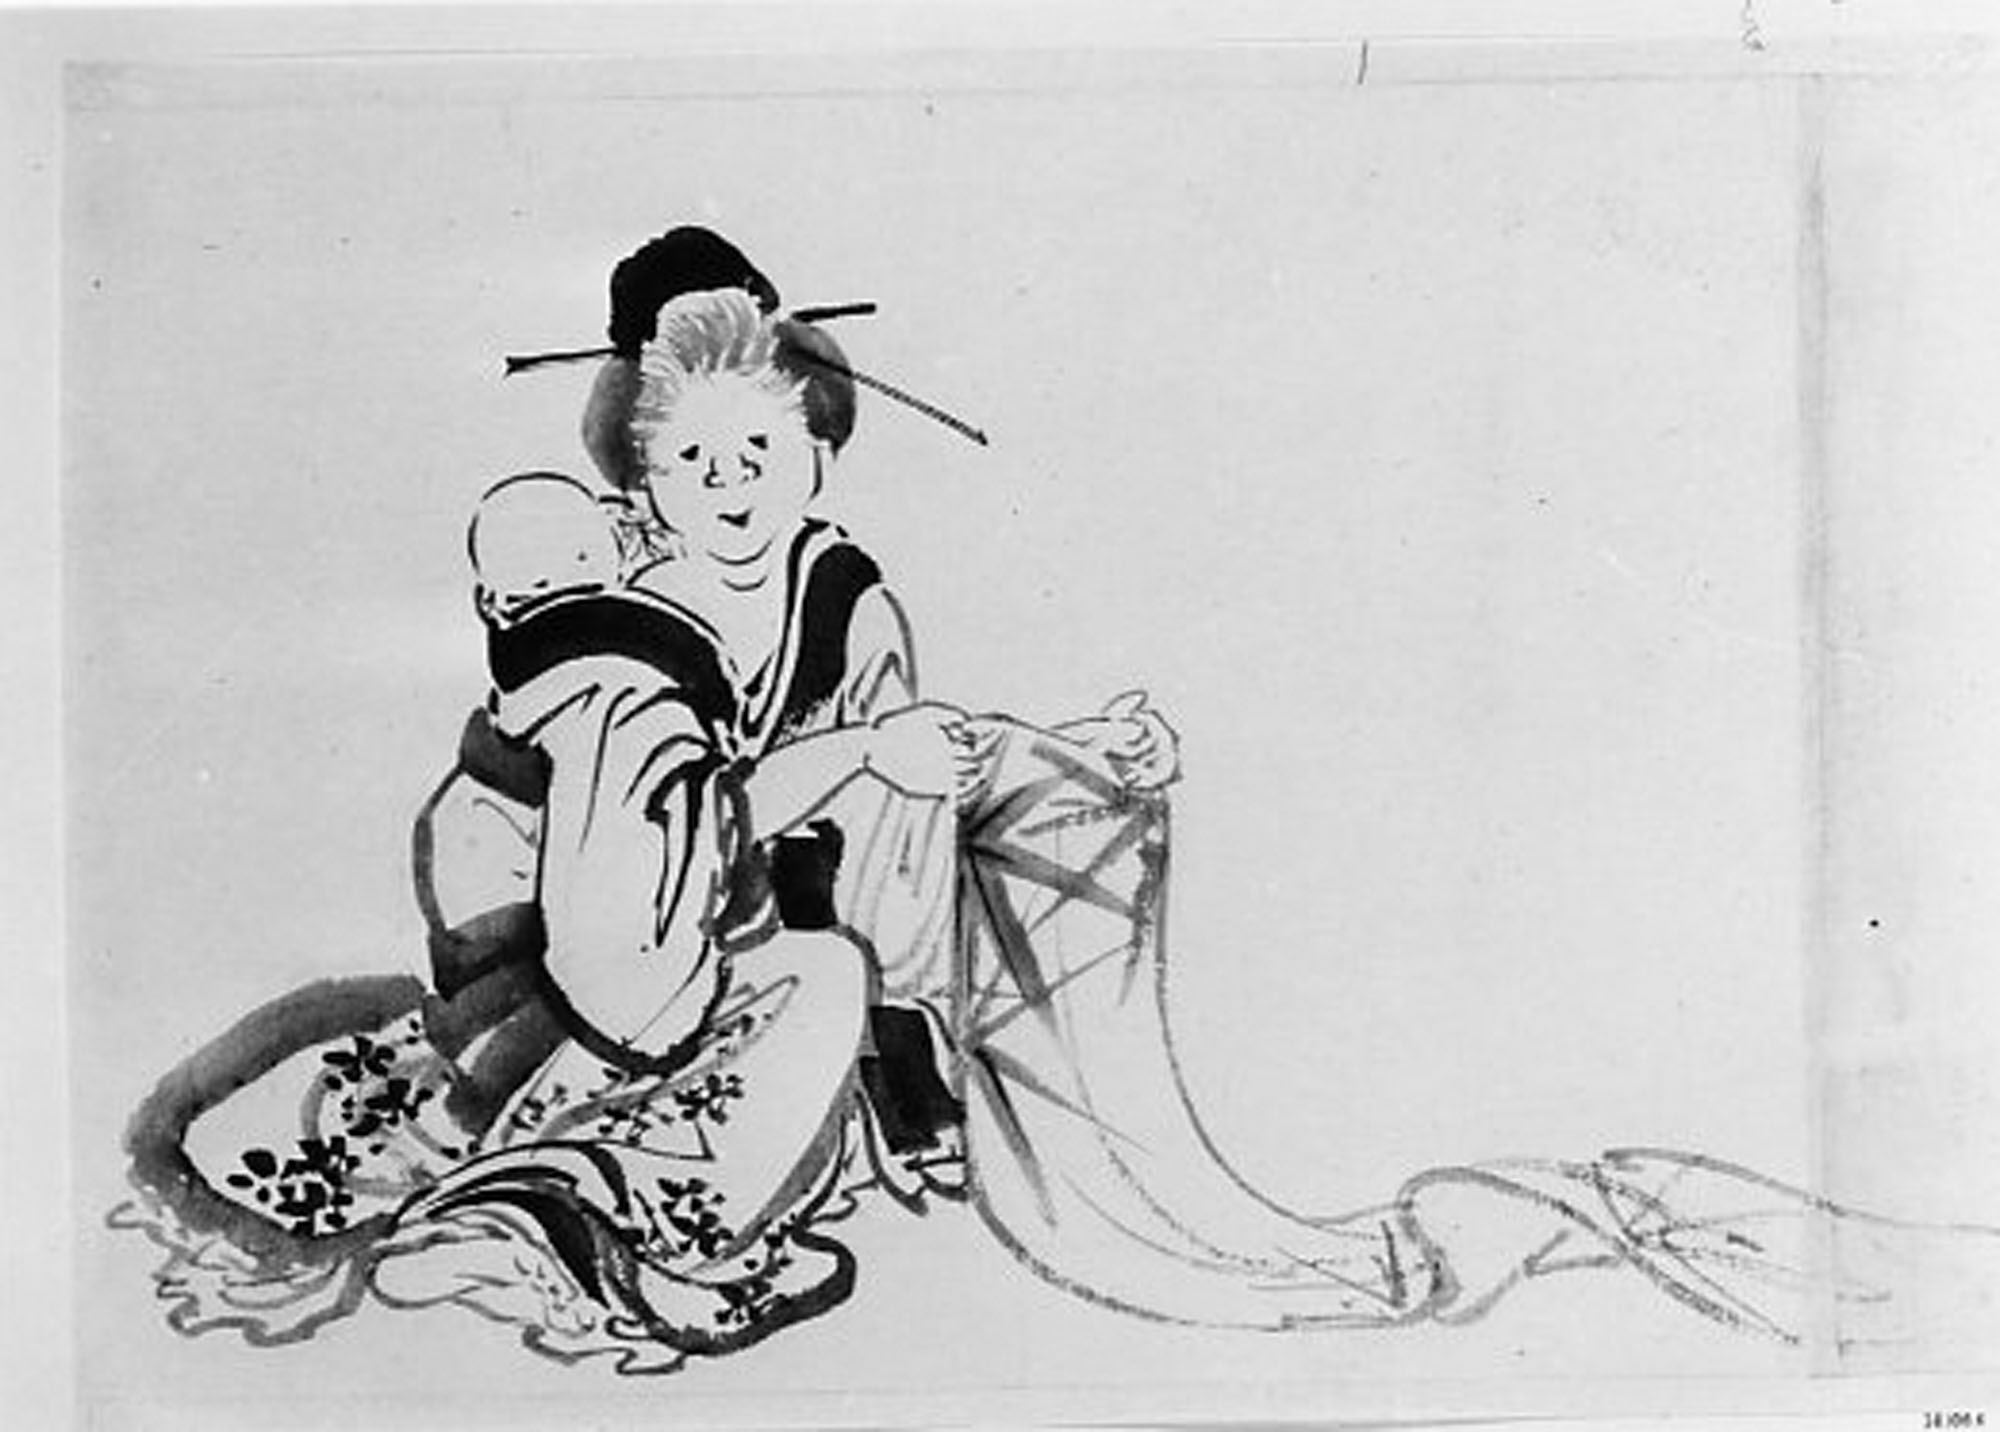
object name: painting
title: Woman with Baby on Her Back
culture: japanese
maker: hokusai school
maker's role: artist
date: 1801-1900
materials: ink, paper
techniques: painting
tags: infants,women